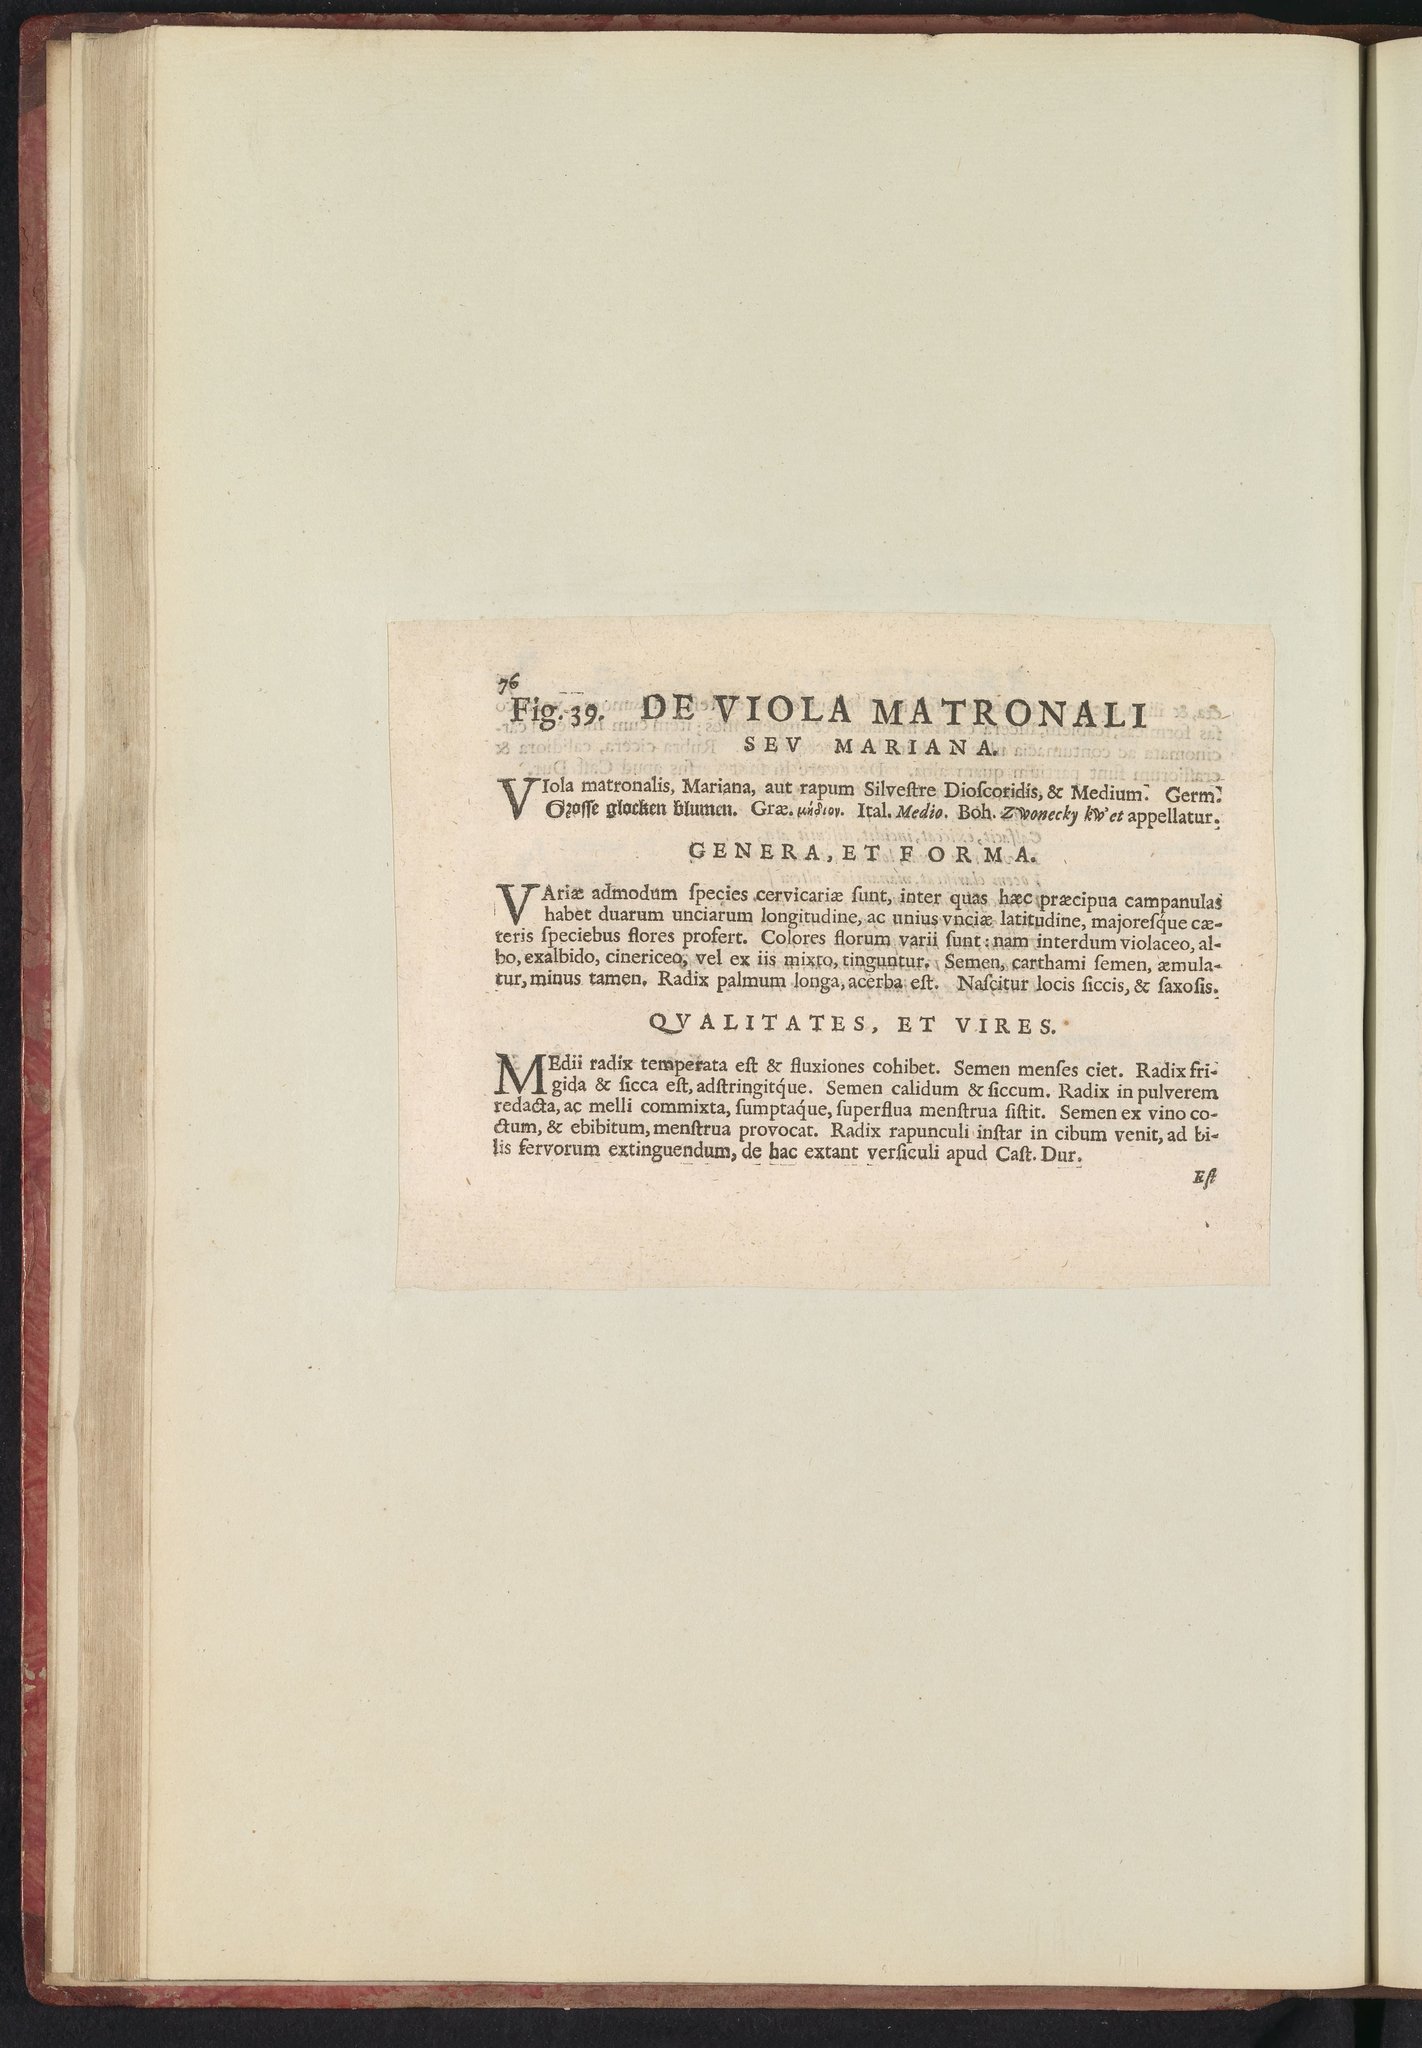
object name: text sheet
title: Fig. 39 'De Viola Matronali' in De Boodts herbarium van 1640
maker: anselmus boëtius de boodt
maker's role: draughtsman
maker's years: 1550-1632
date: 1640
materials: ink, paper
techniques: letterpress printing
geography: bruges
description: Beschrijving bij Fig. 39 op p. 76 in: Anselmi Boëtii de Boot I.C. Brugensis & Rodolphi II. Imp. Roman. medici a cubiculis Florum, Herbarum, ac fructuum selectiorum icones, & vires pleraeque hactenus ignotæ. Onderdeel van het album met bladen en platen uit De Boodts herbarium van 1640. Het twaalfde van twaalf albums met aquarellen van dieren, vogels en planten bekend rond 1600, gemaakt in opdracht van keizer Rudolf II.